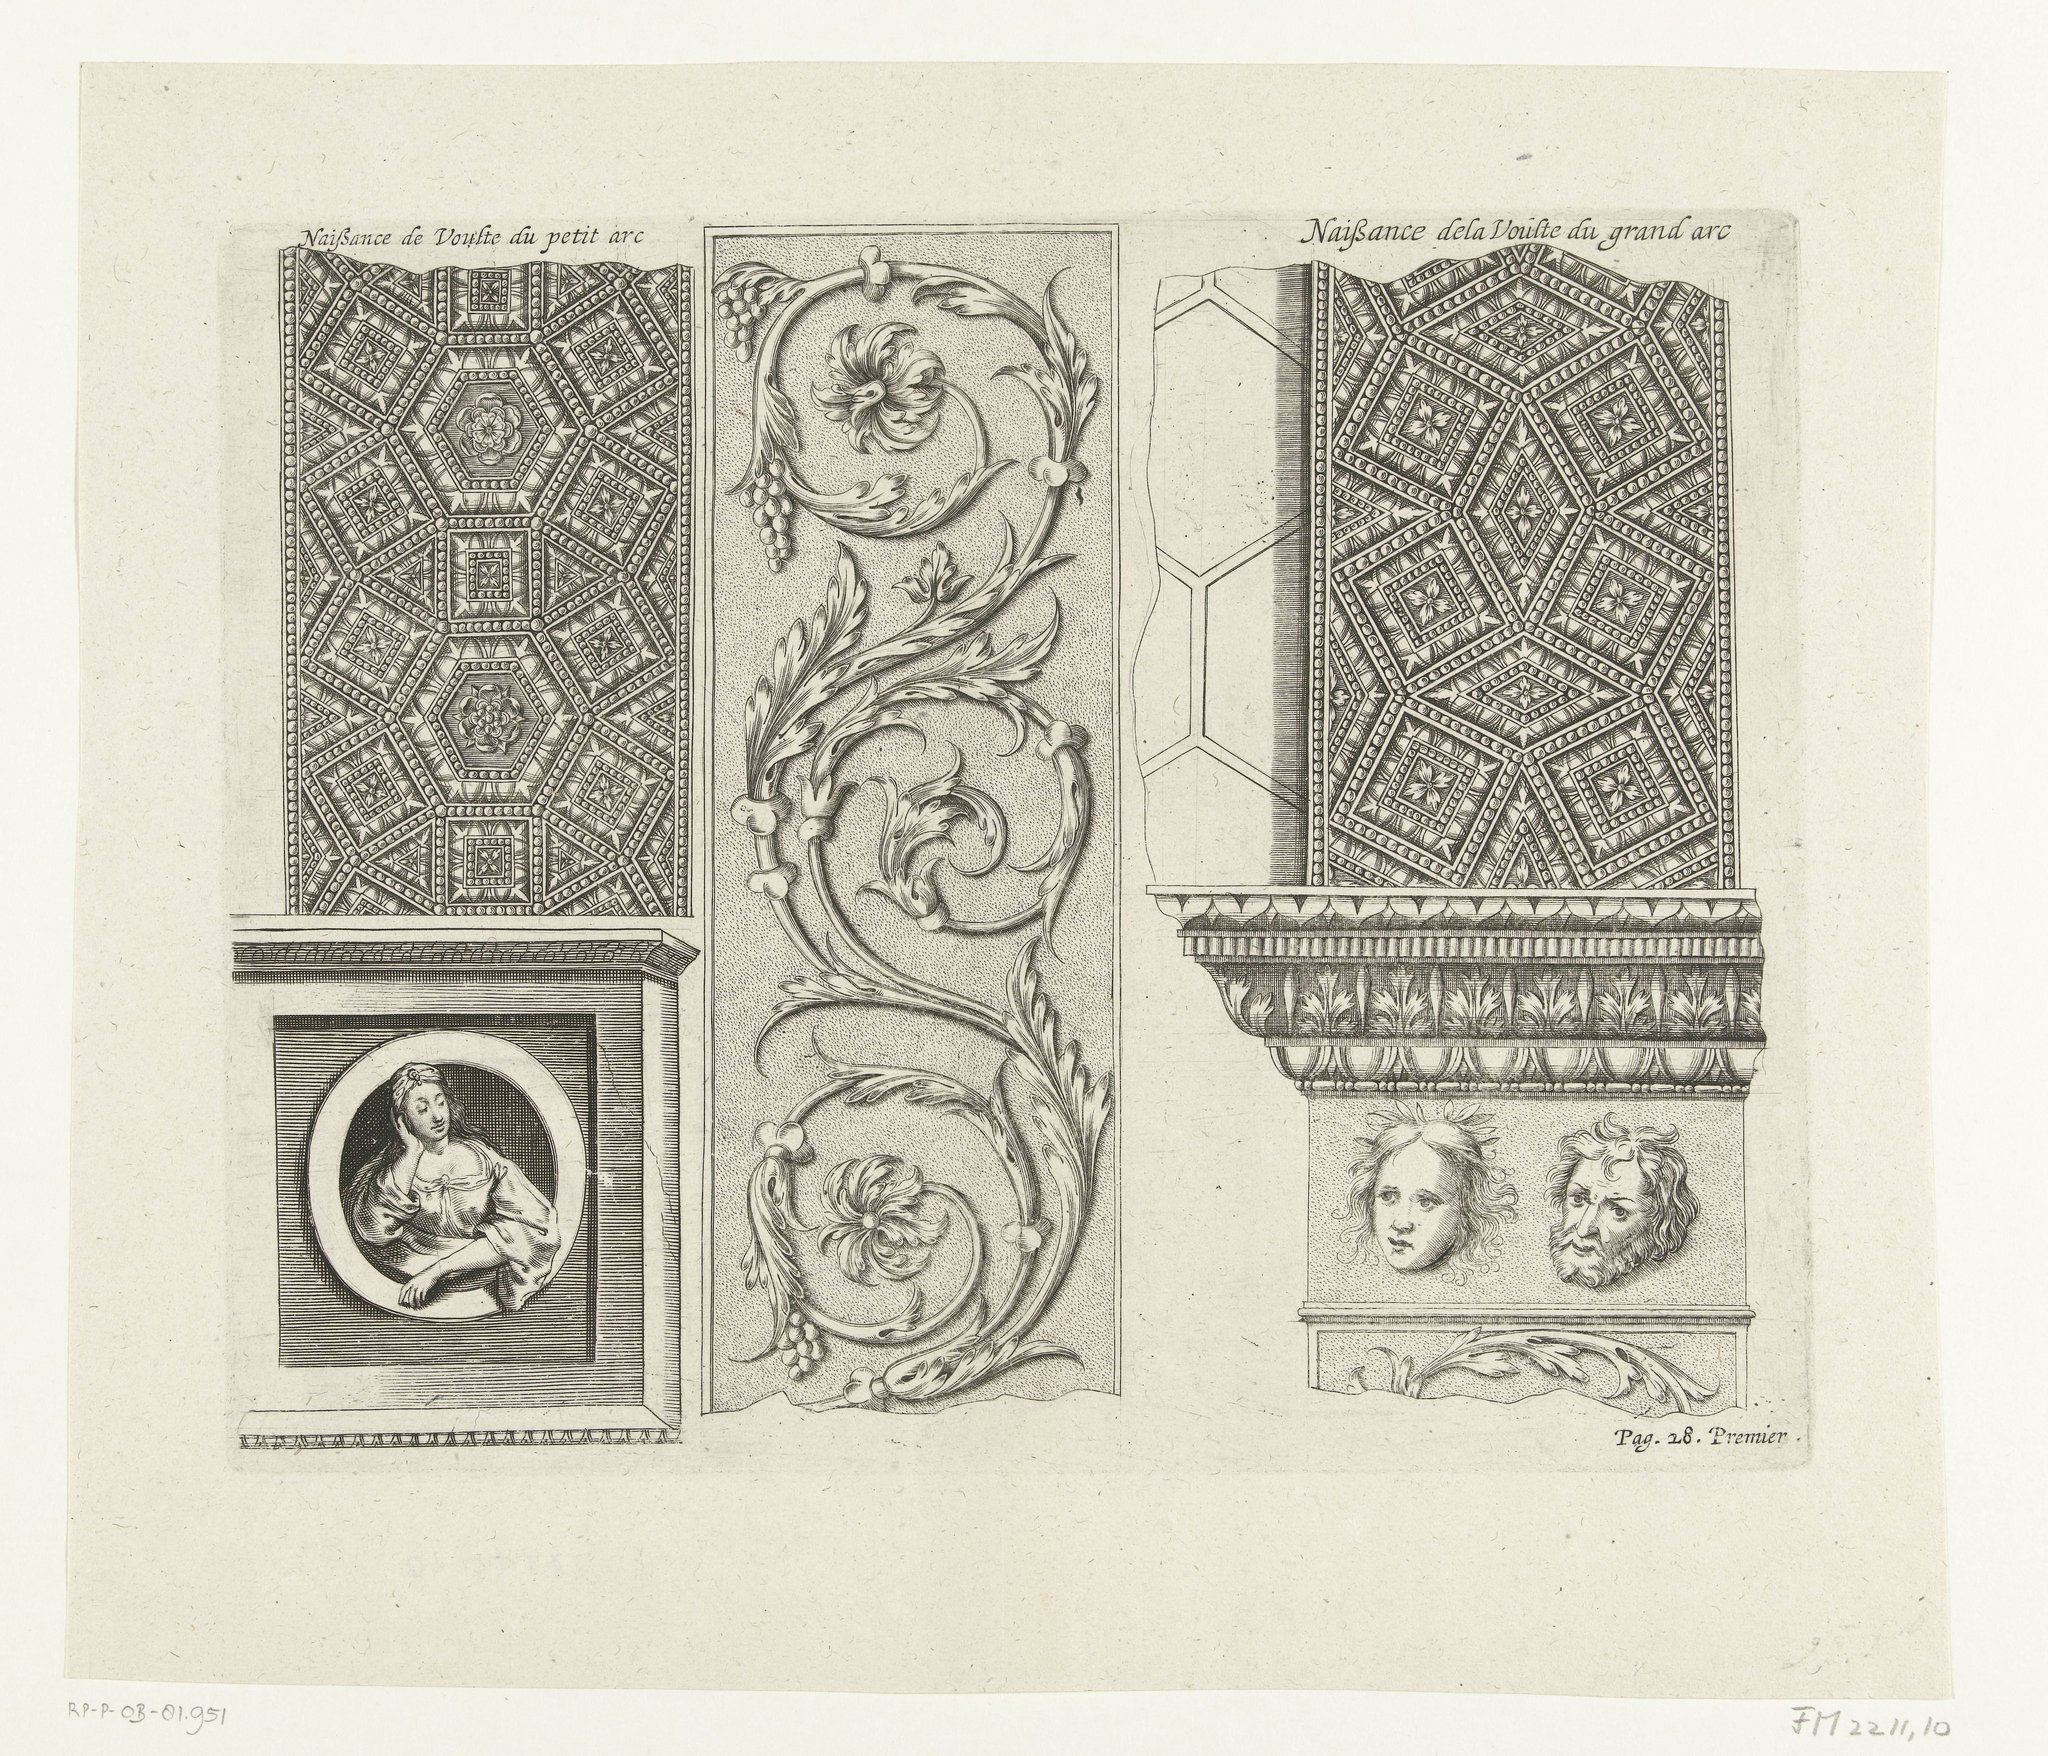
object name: print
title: Ornamenten op de Romeinse triomfboog in Orange, 1639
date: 1637-1640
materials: paper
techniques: engraving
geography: france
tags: ornaments ~ art, triumphal arch, piece of sculpture, reproduction of a piece of sculpture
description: Gebruikt als illustratie in: Joseph de la Pisé, Tableau de l'histoire des princes et principauté d'Orange, Den Haag, 1639-1640, p. 28.